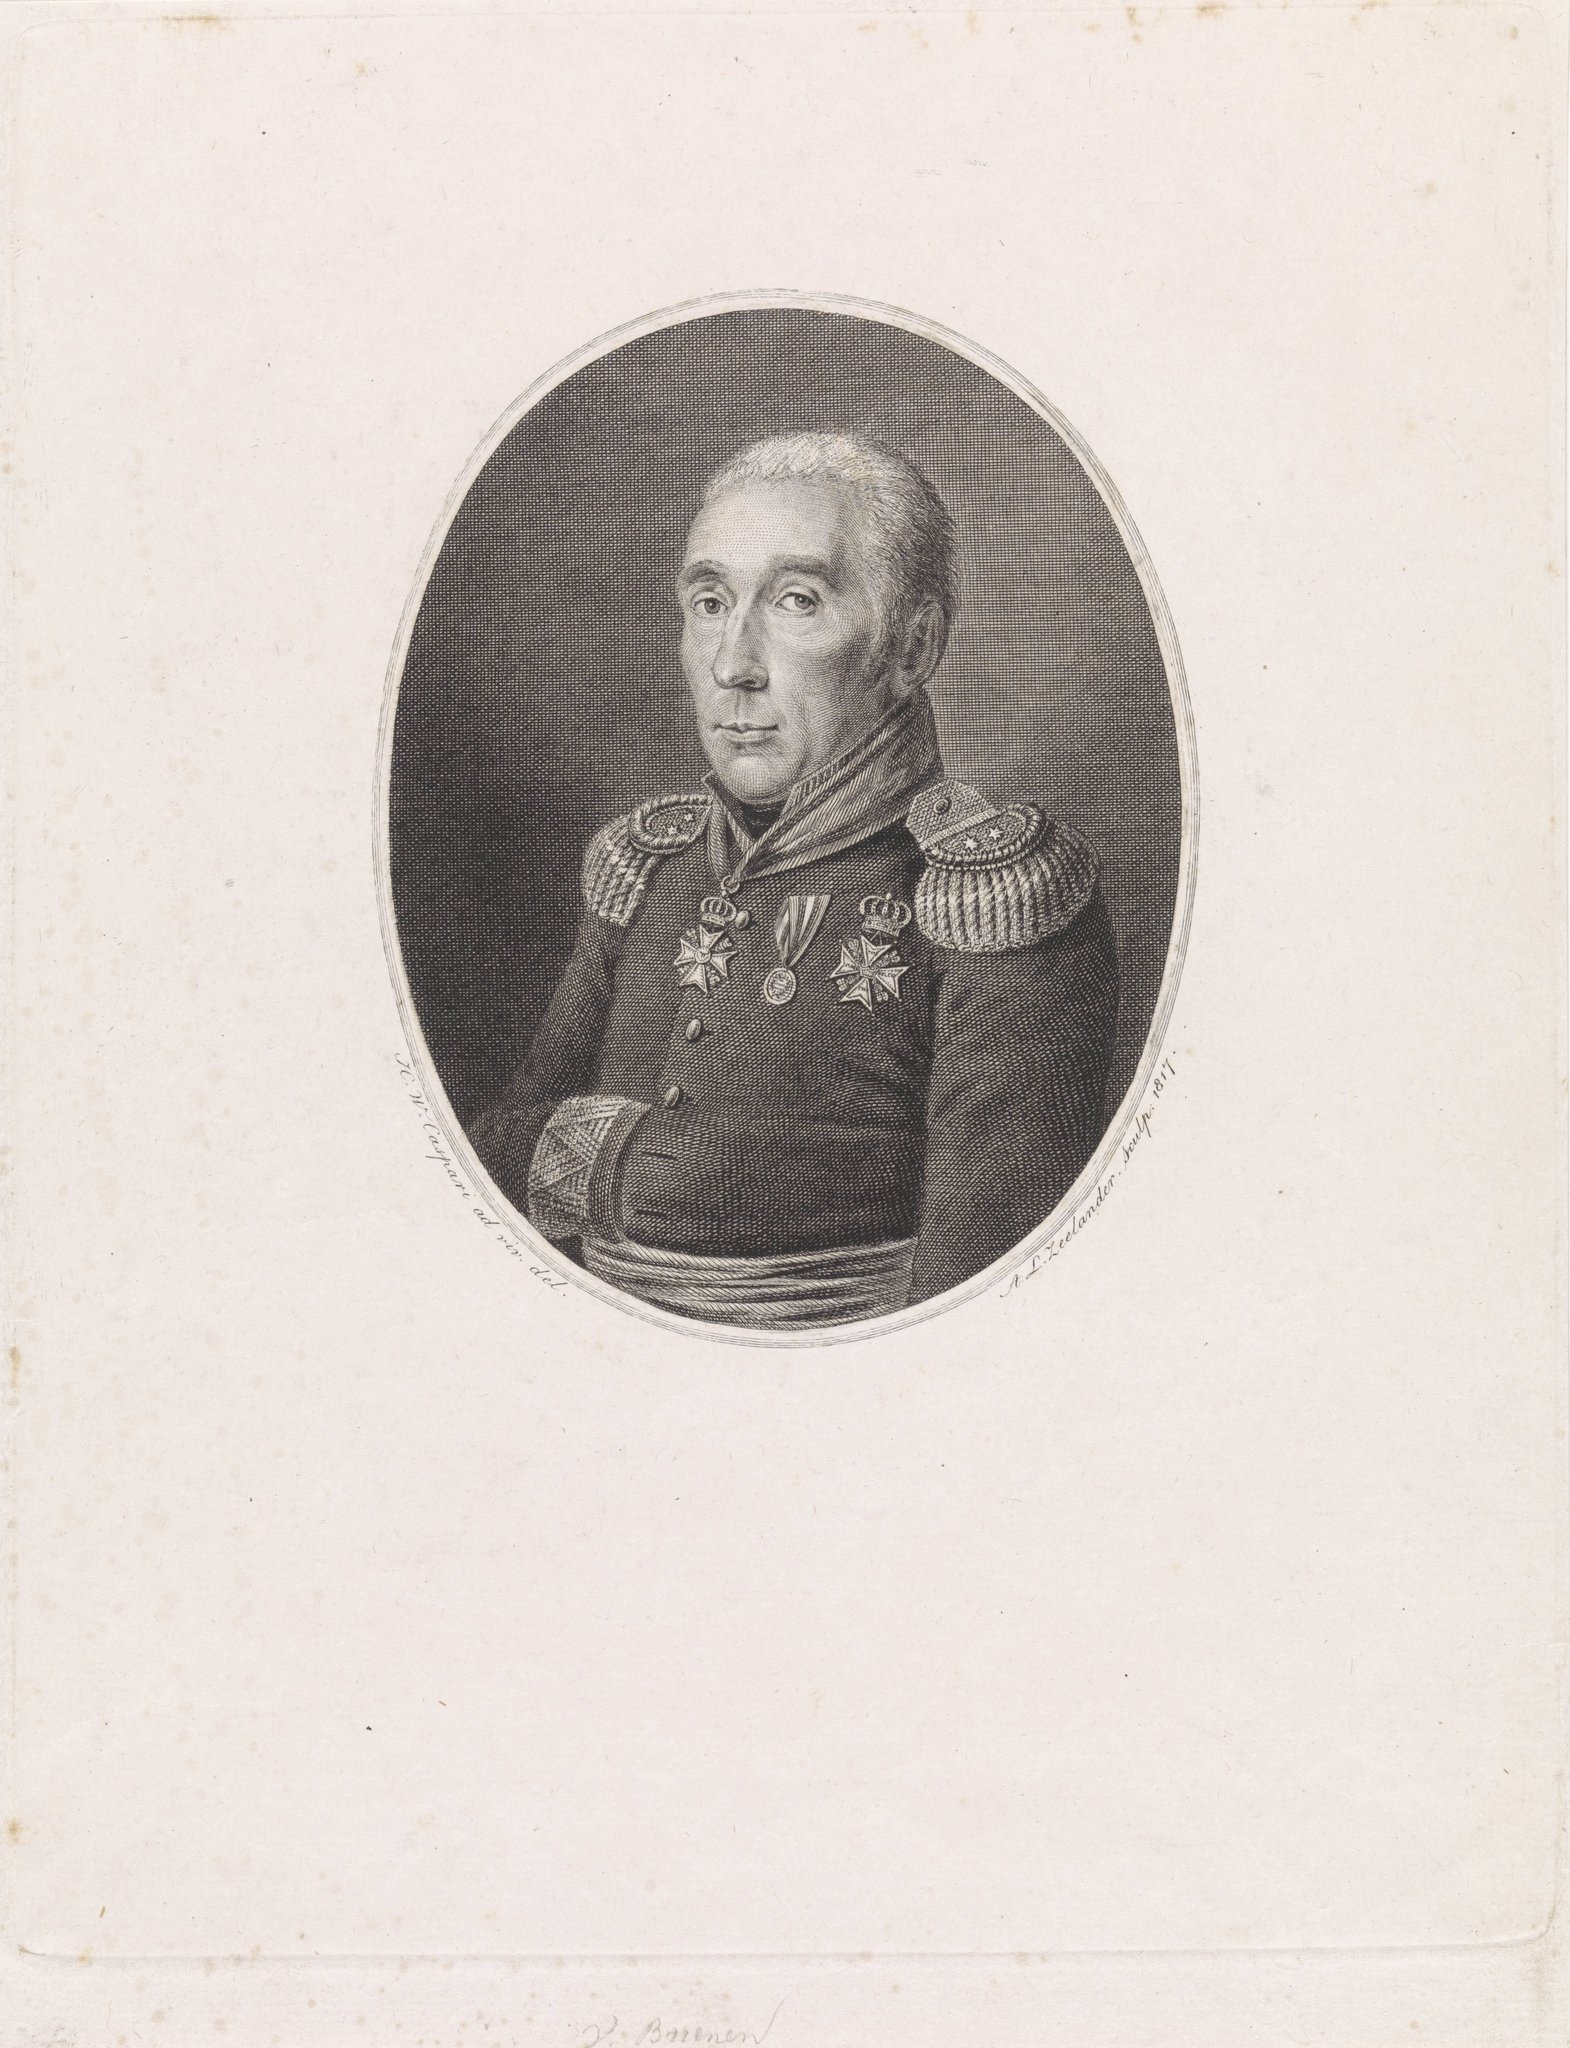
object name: print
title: Portret van Gijsbert Carel Rutger Reinier van Brienen van Ramerus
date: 1817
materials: paper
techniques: engraving, etching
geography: amsterdam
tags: gijsbert carel rutger reinier van brienen van ramerus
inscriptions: collector's mark: Lugt 2233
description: Portret van Gijsbert Carel Rutger Reinier van Brienen van Ramerus, commandeur in de Militaire Willems-Orde.